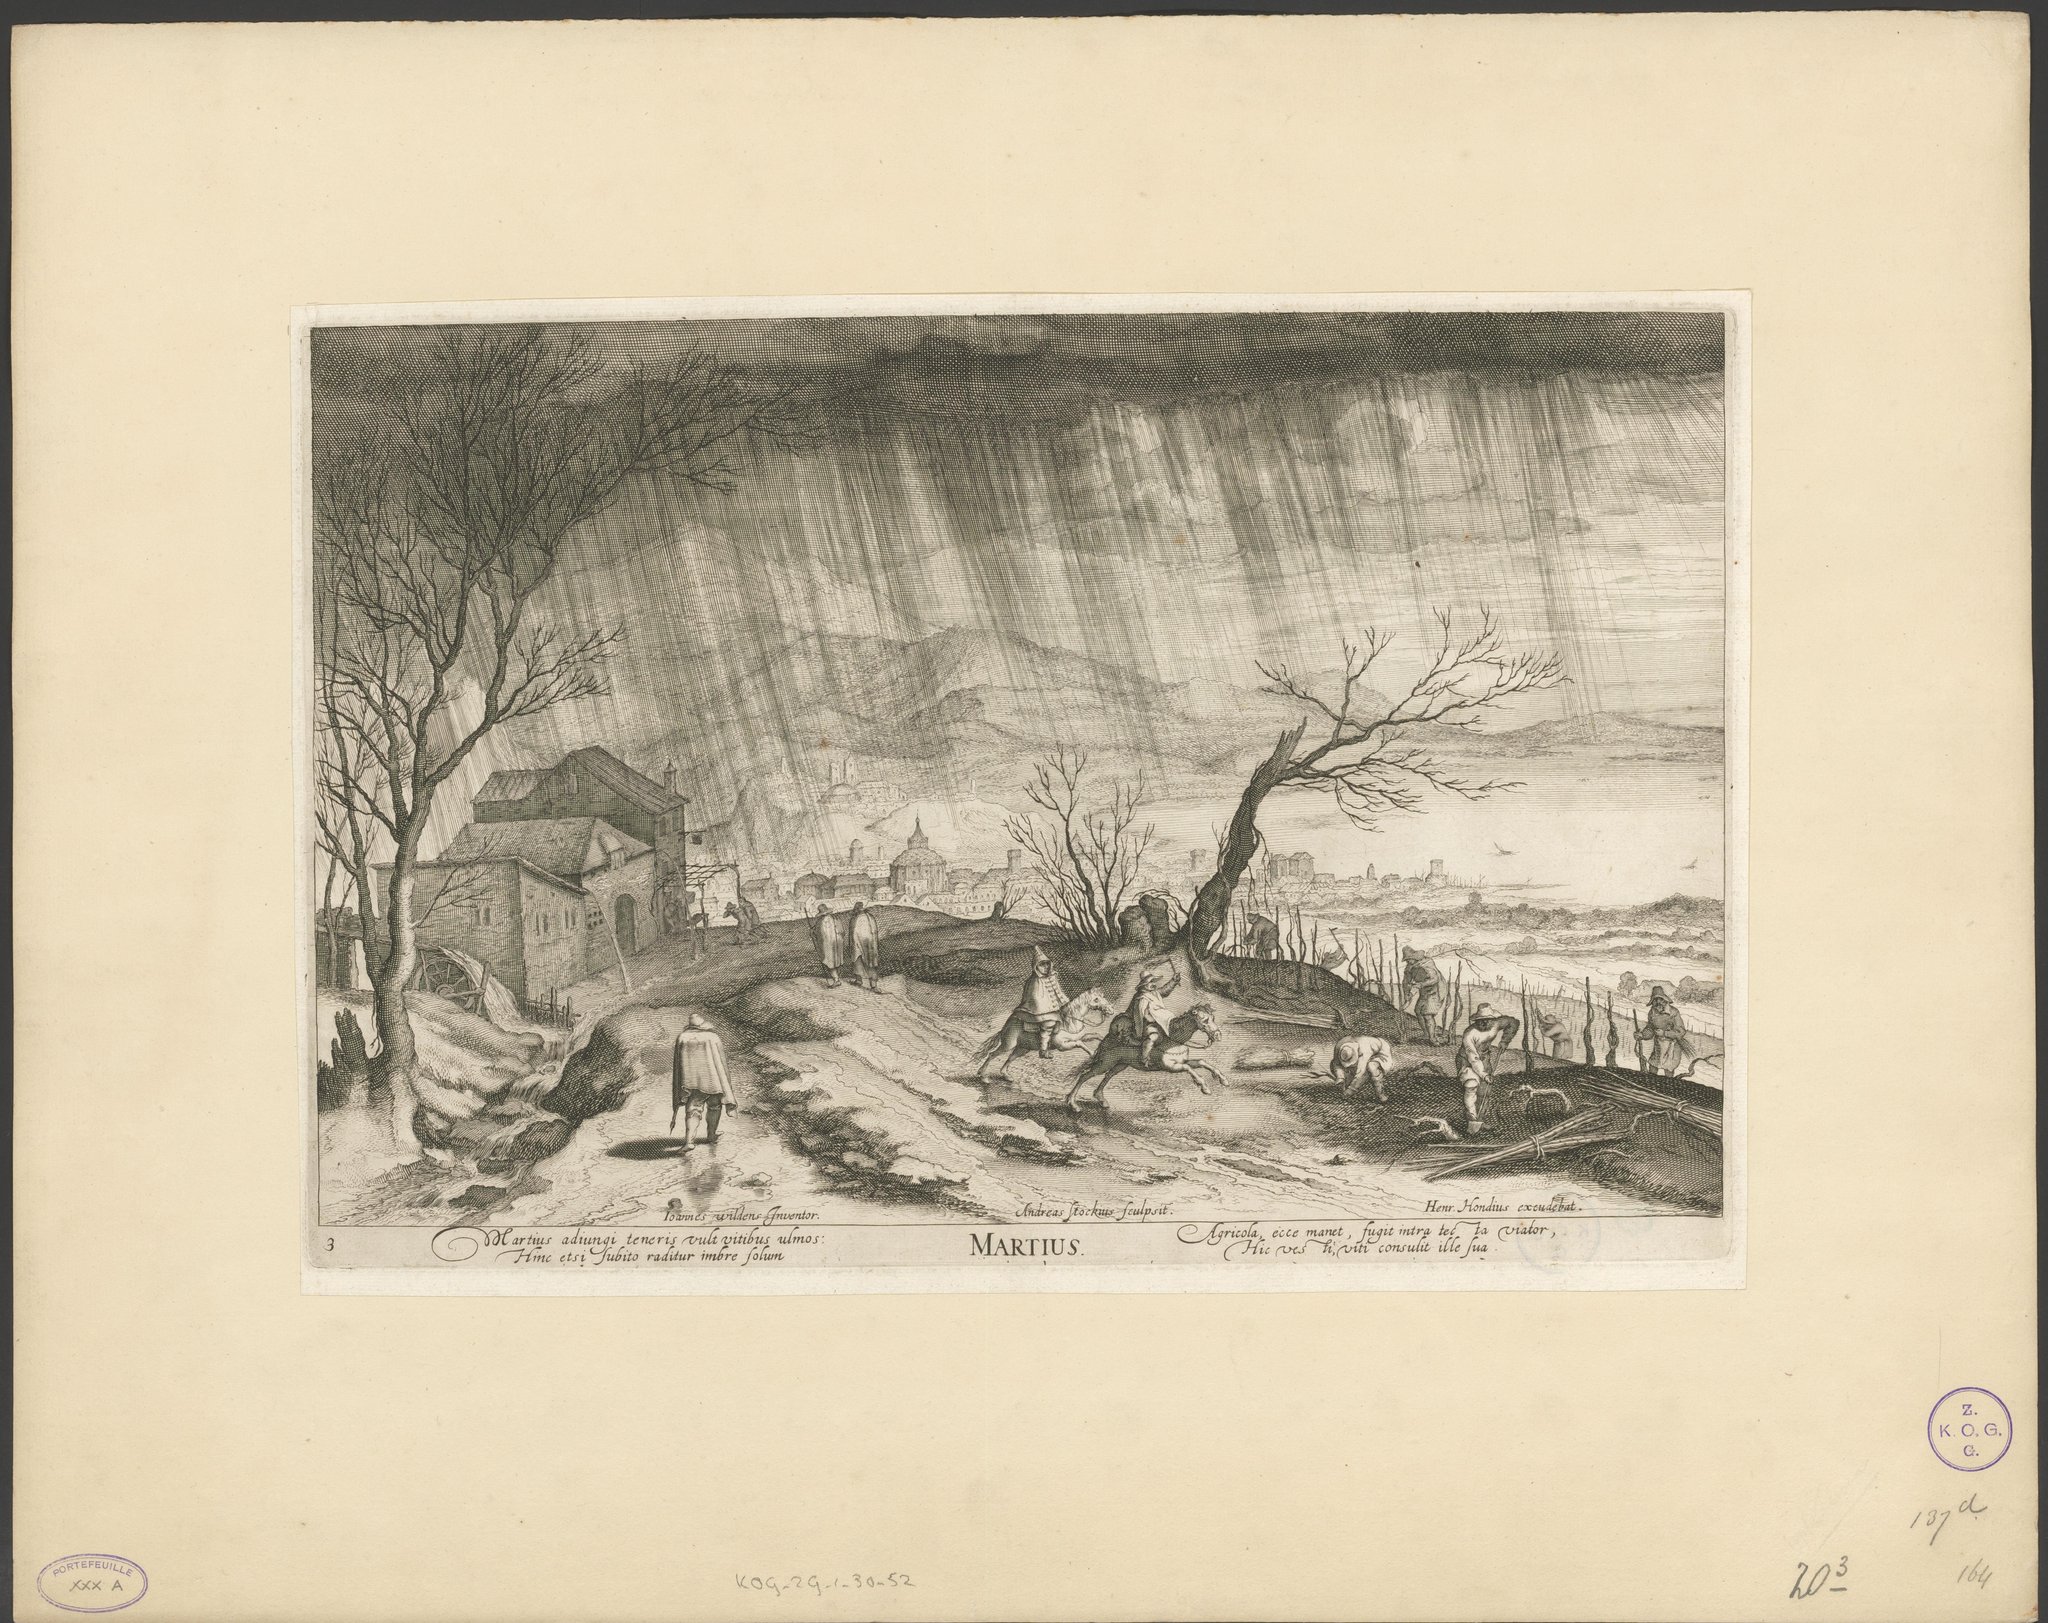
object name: print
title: Maart, landschap met een regenbui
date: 1614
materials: paper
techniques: engraving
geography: the hague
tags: landscape symbolizing march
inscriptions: stamp: 963, collector's mark: Lugt 1641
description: Landschap met op de voorgrond boeren die land bewerken en hout sprokkelen en ruiters op een weg. In het verschiet een stad en bergen. Er valt regen uit donkere wolken. Verbeelding van de maand Maart. Prent uit een serie van de twaalf maanden. Onderaan een vierregelig vers in twee kolommen in het Latijn. Onderwerpsrubrieken binnen de Atlas Zeden en Gewoonten: Zeden en Gewoonten in engeren zin. Volksleven. Zinnebeeldige voorstellingen uit het volkleven op serieprenten. Maanden en diversen (allegorieën).